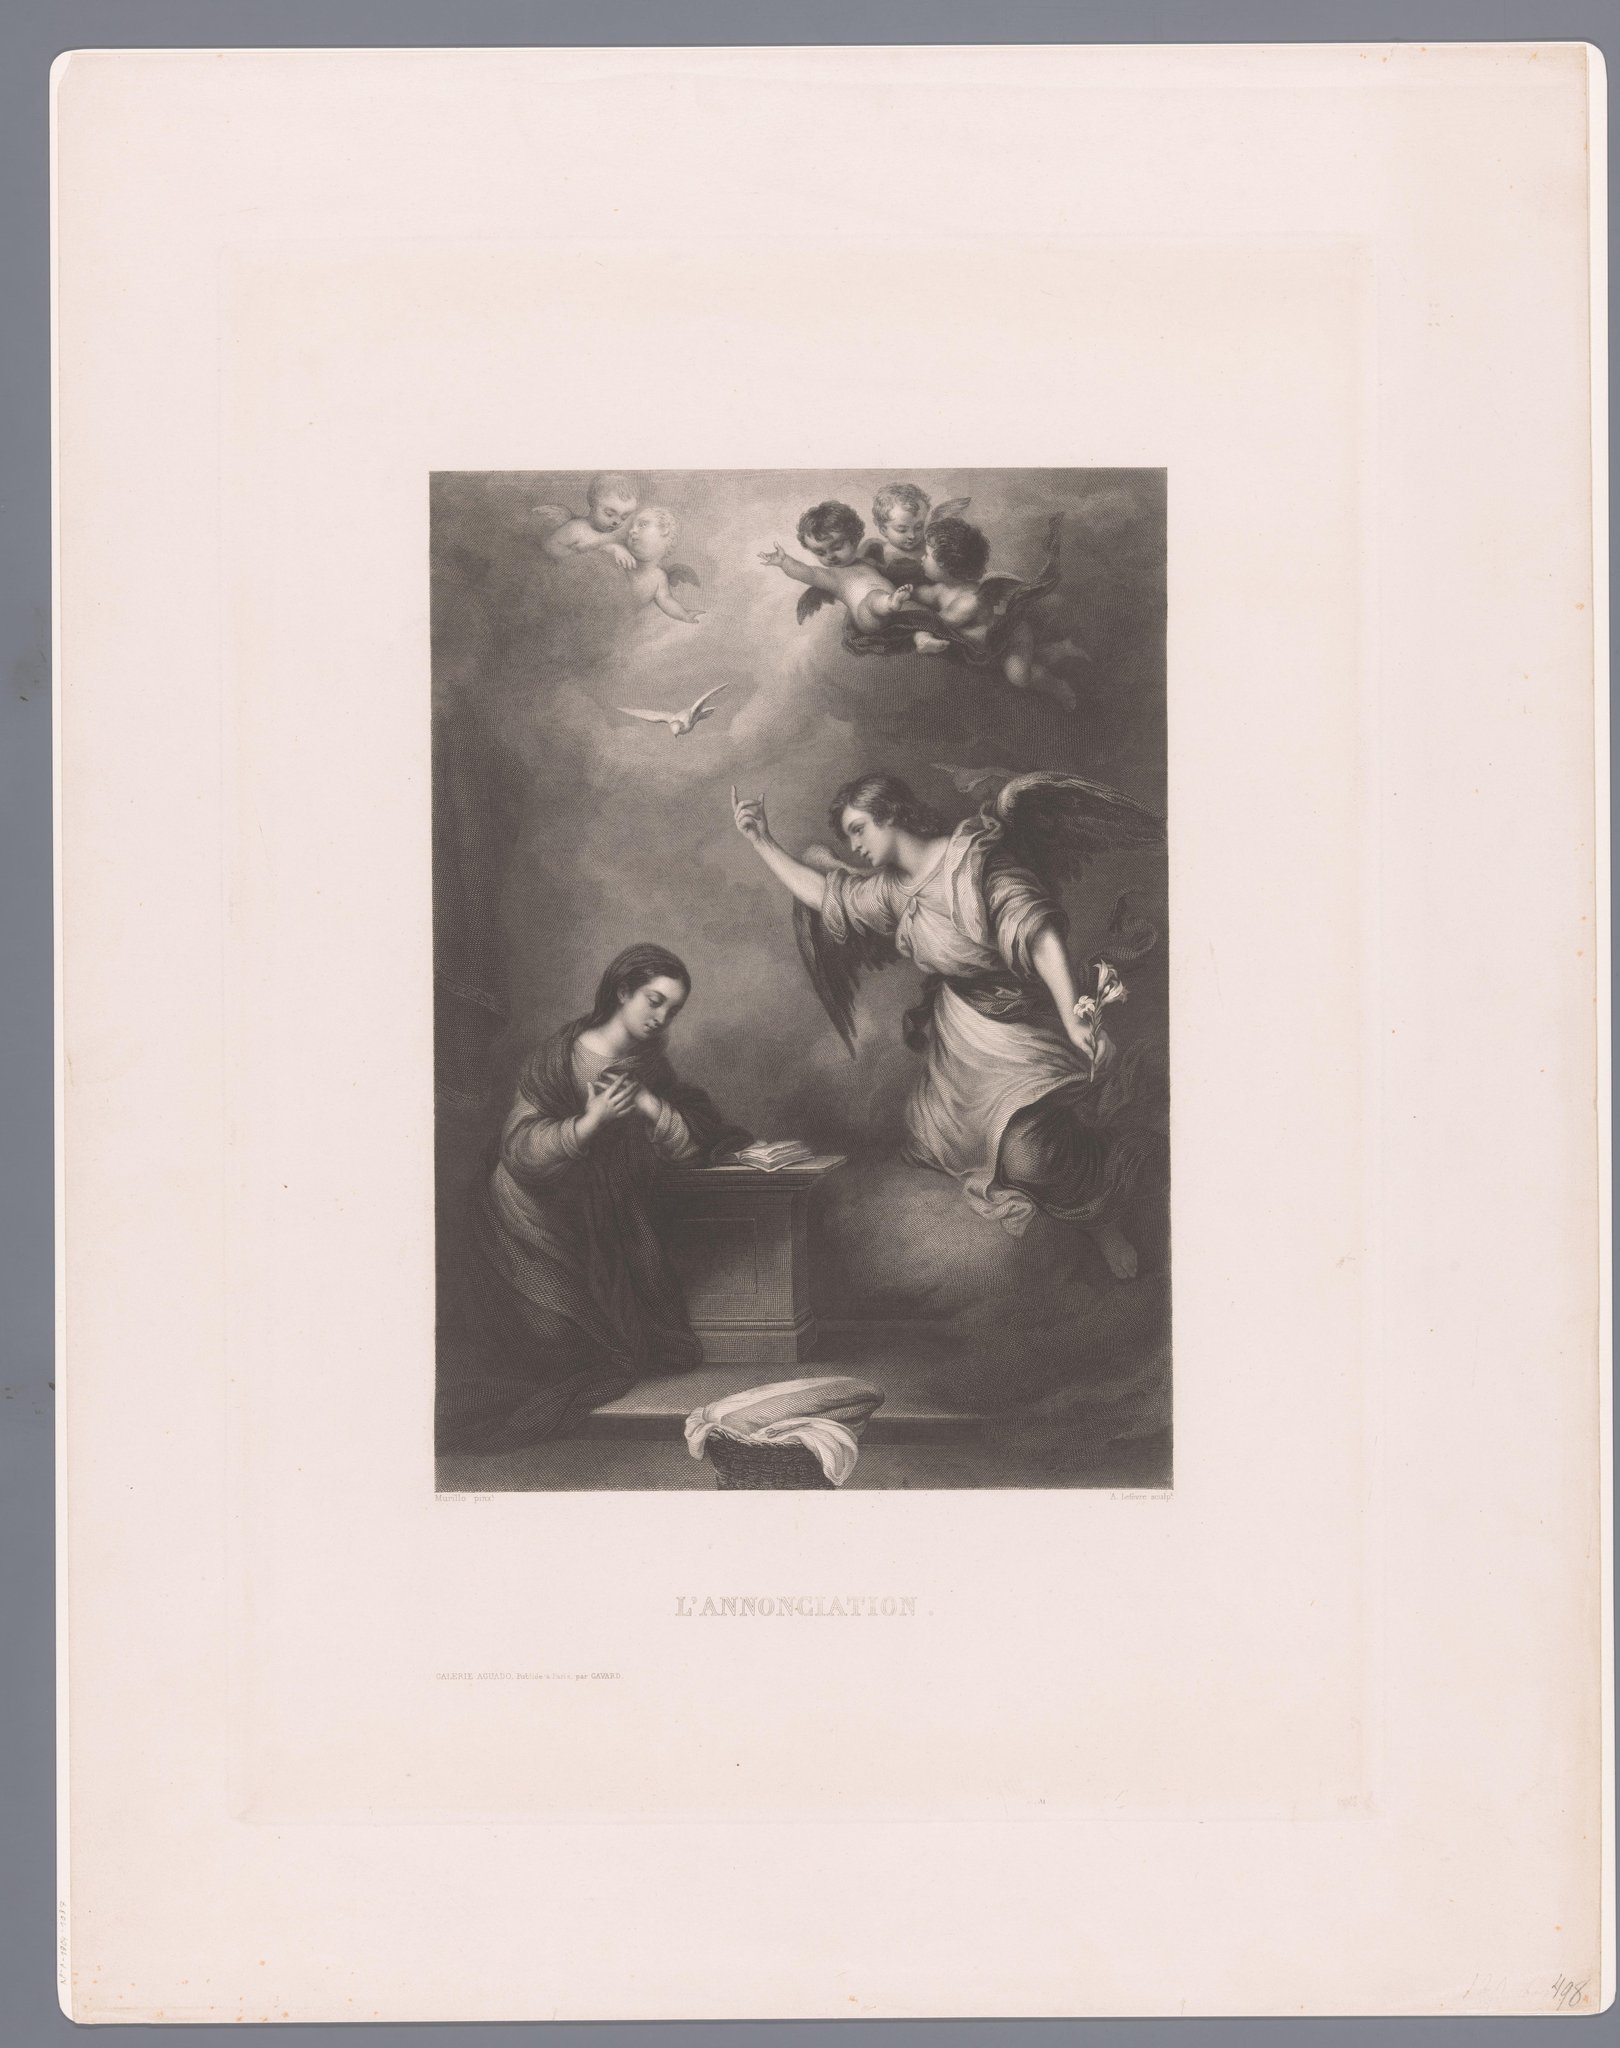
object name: print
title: Annunciatie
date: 1808-1864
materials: paper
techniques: engraving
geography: france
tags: the annunciation: mary kneeling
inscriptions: collector's mark: Lugt 2228